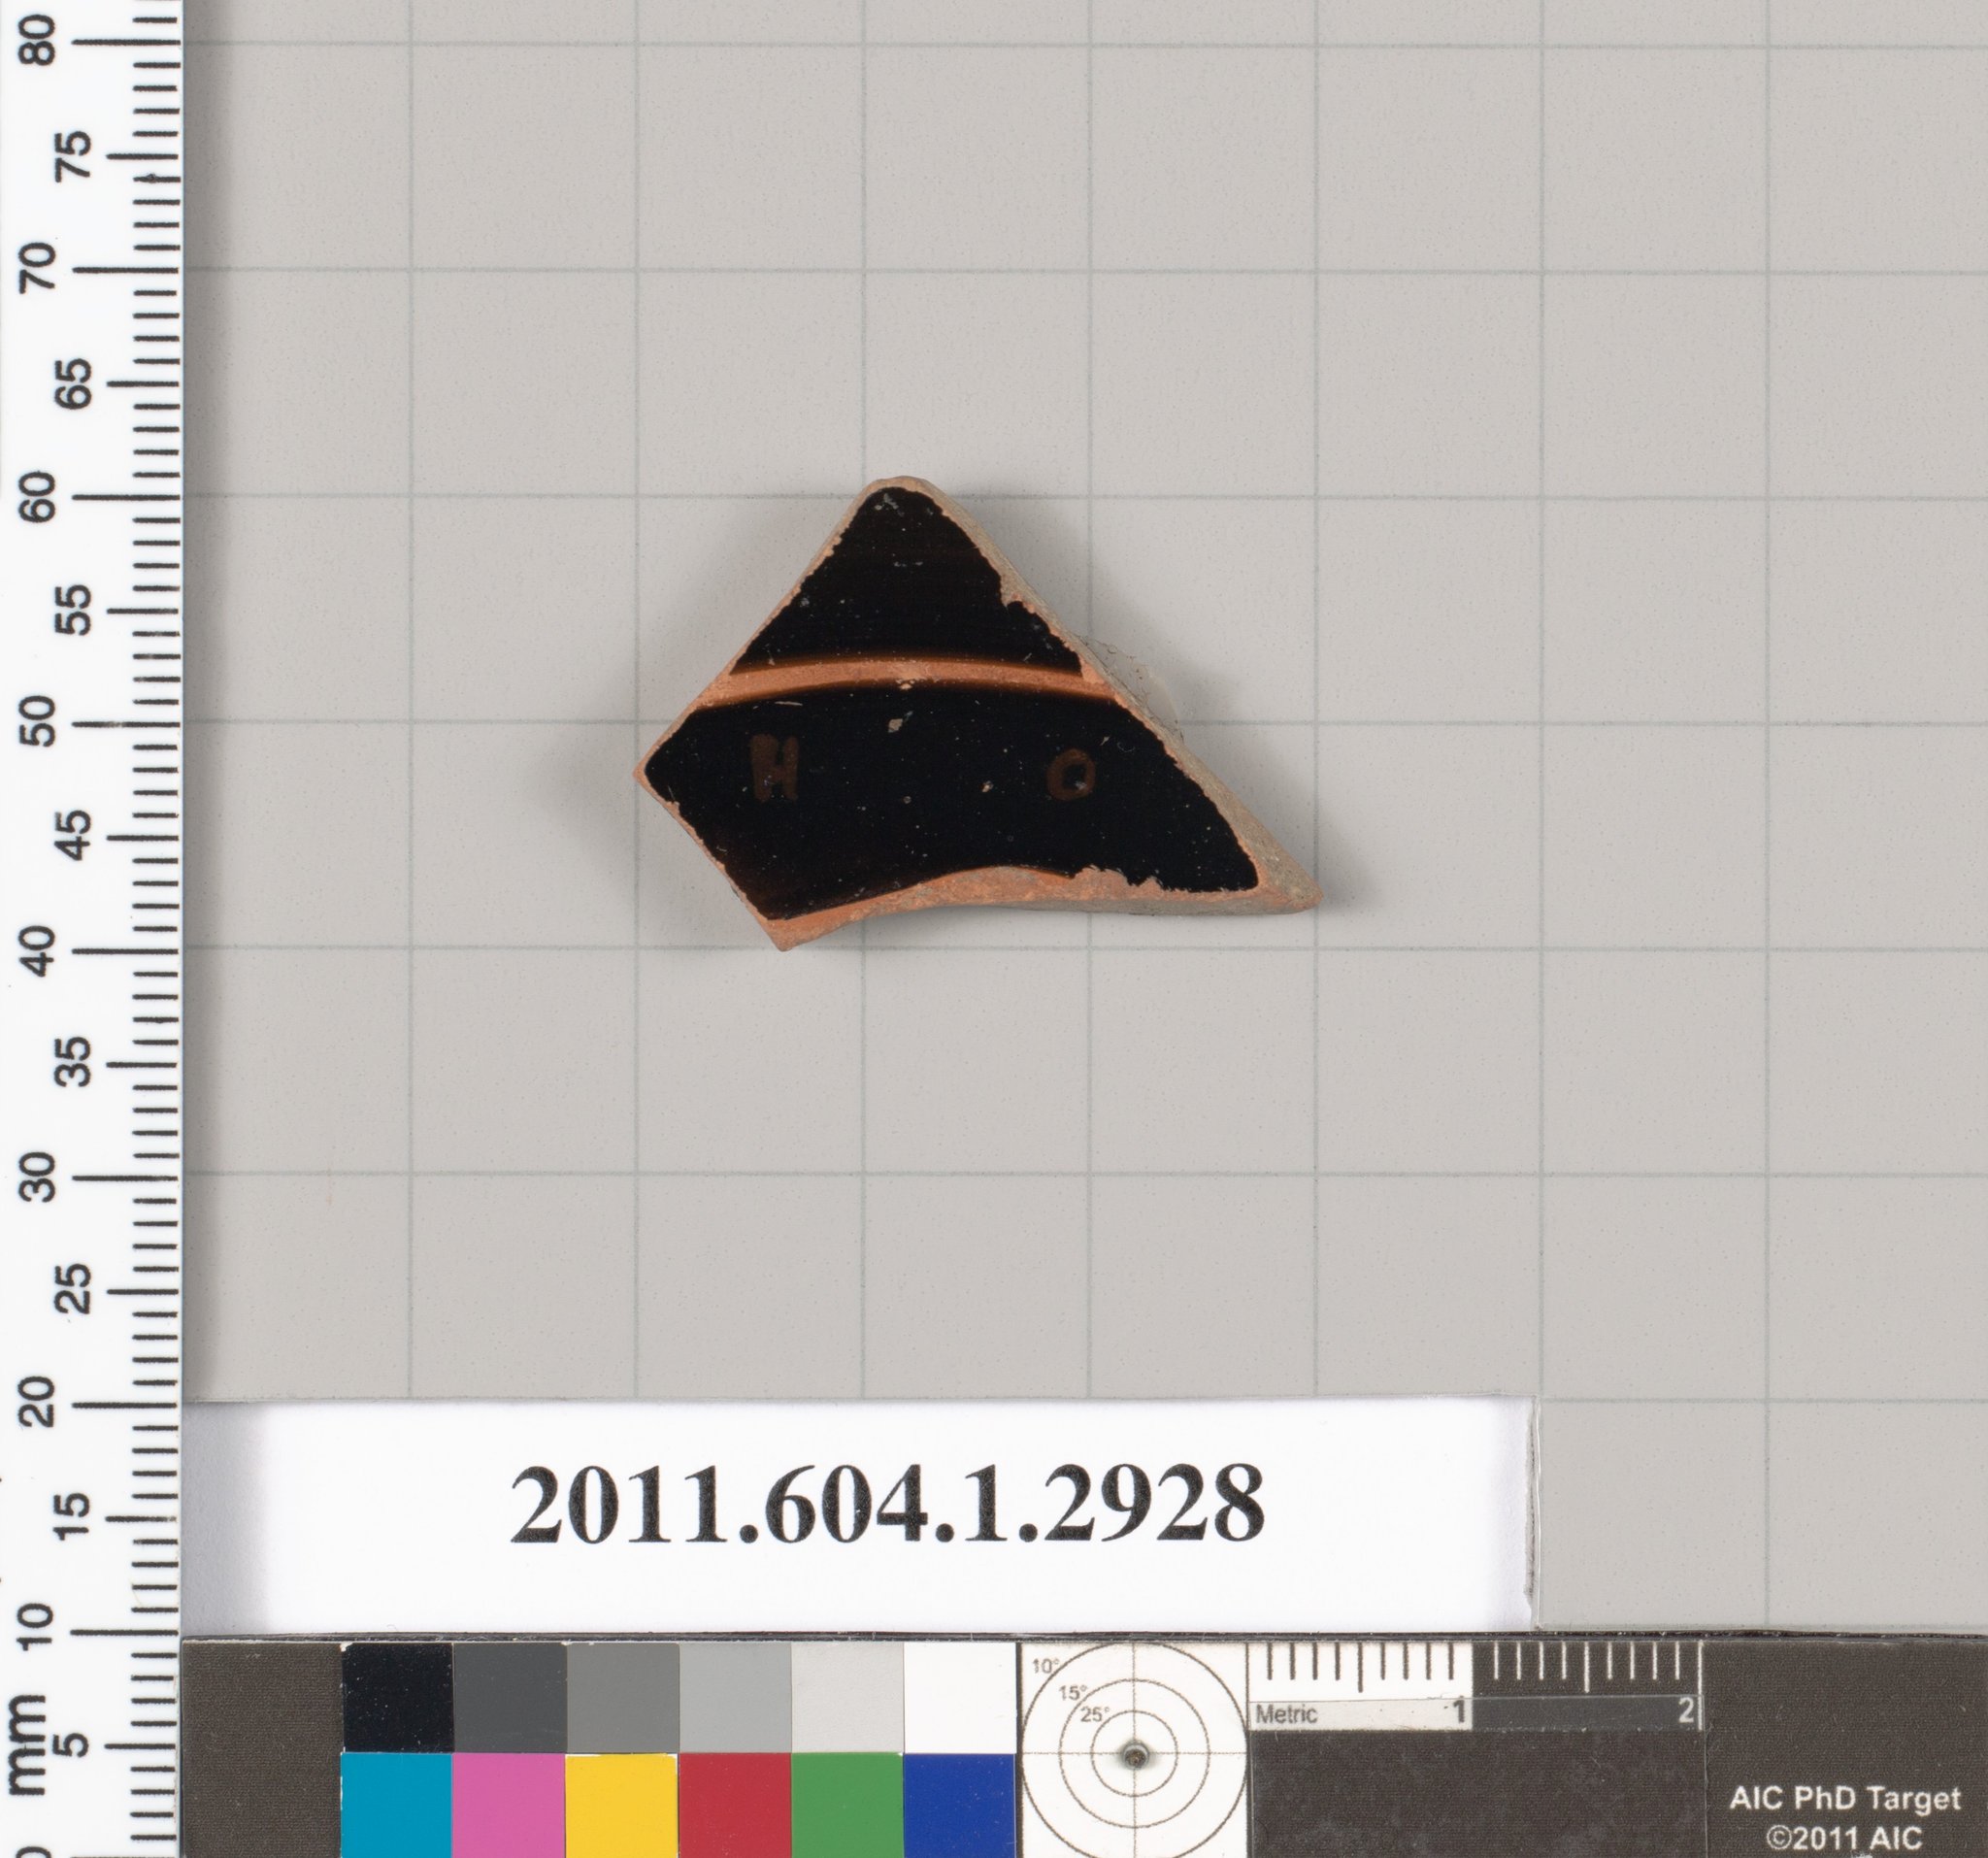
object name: kylix fragment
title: Terracotta fragment of a kylix (drinking cup)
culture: greek, attic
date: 600-401 BCE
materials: terracotta